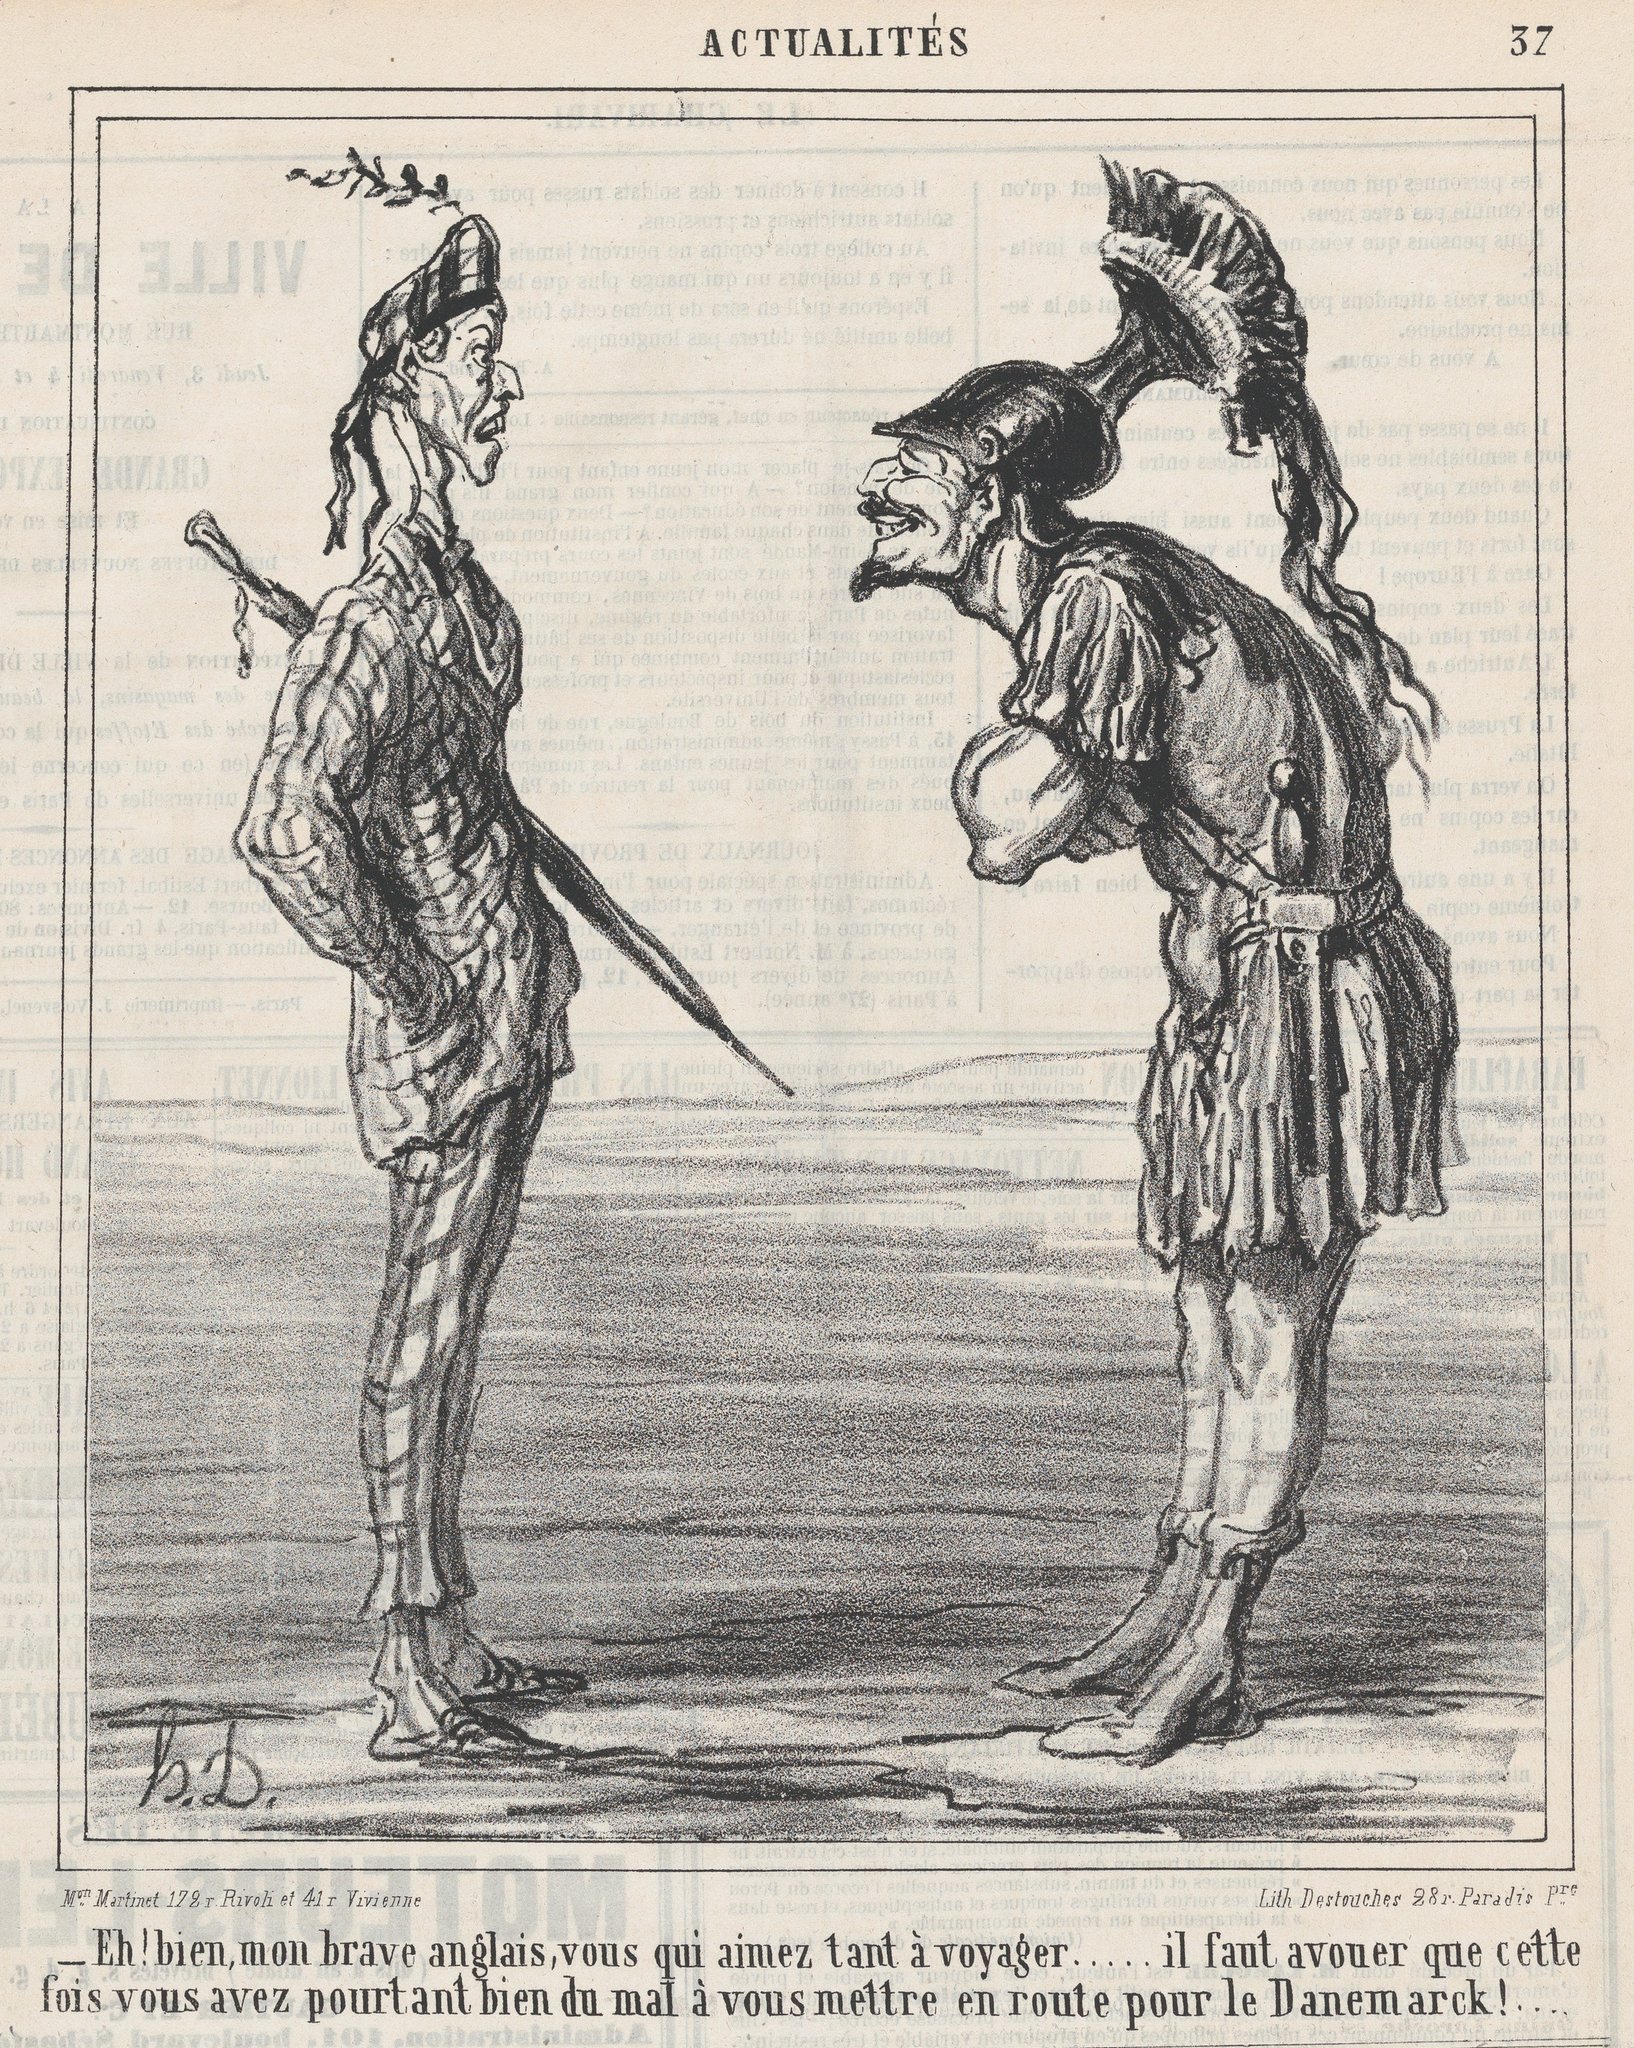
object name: print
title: Well, my brave Englishman..., from 'News of the day,' published in Le Charivari, March 5, 1864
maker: honoré daumier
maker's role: artist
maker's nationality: french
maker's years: 1808-1879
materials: paper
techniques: lithograph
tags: satire,men